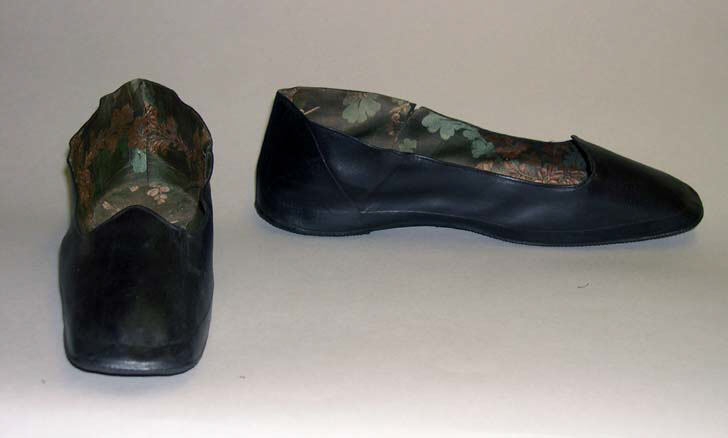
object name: overshoe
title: Overshoes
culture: american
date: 1845-1850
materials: rubber, silk